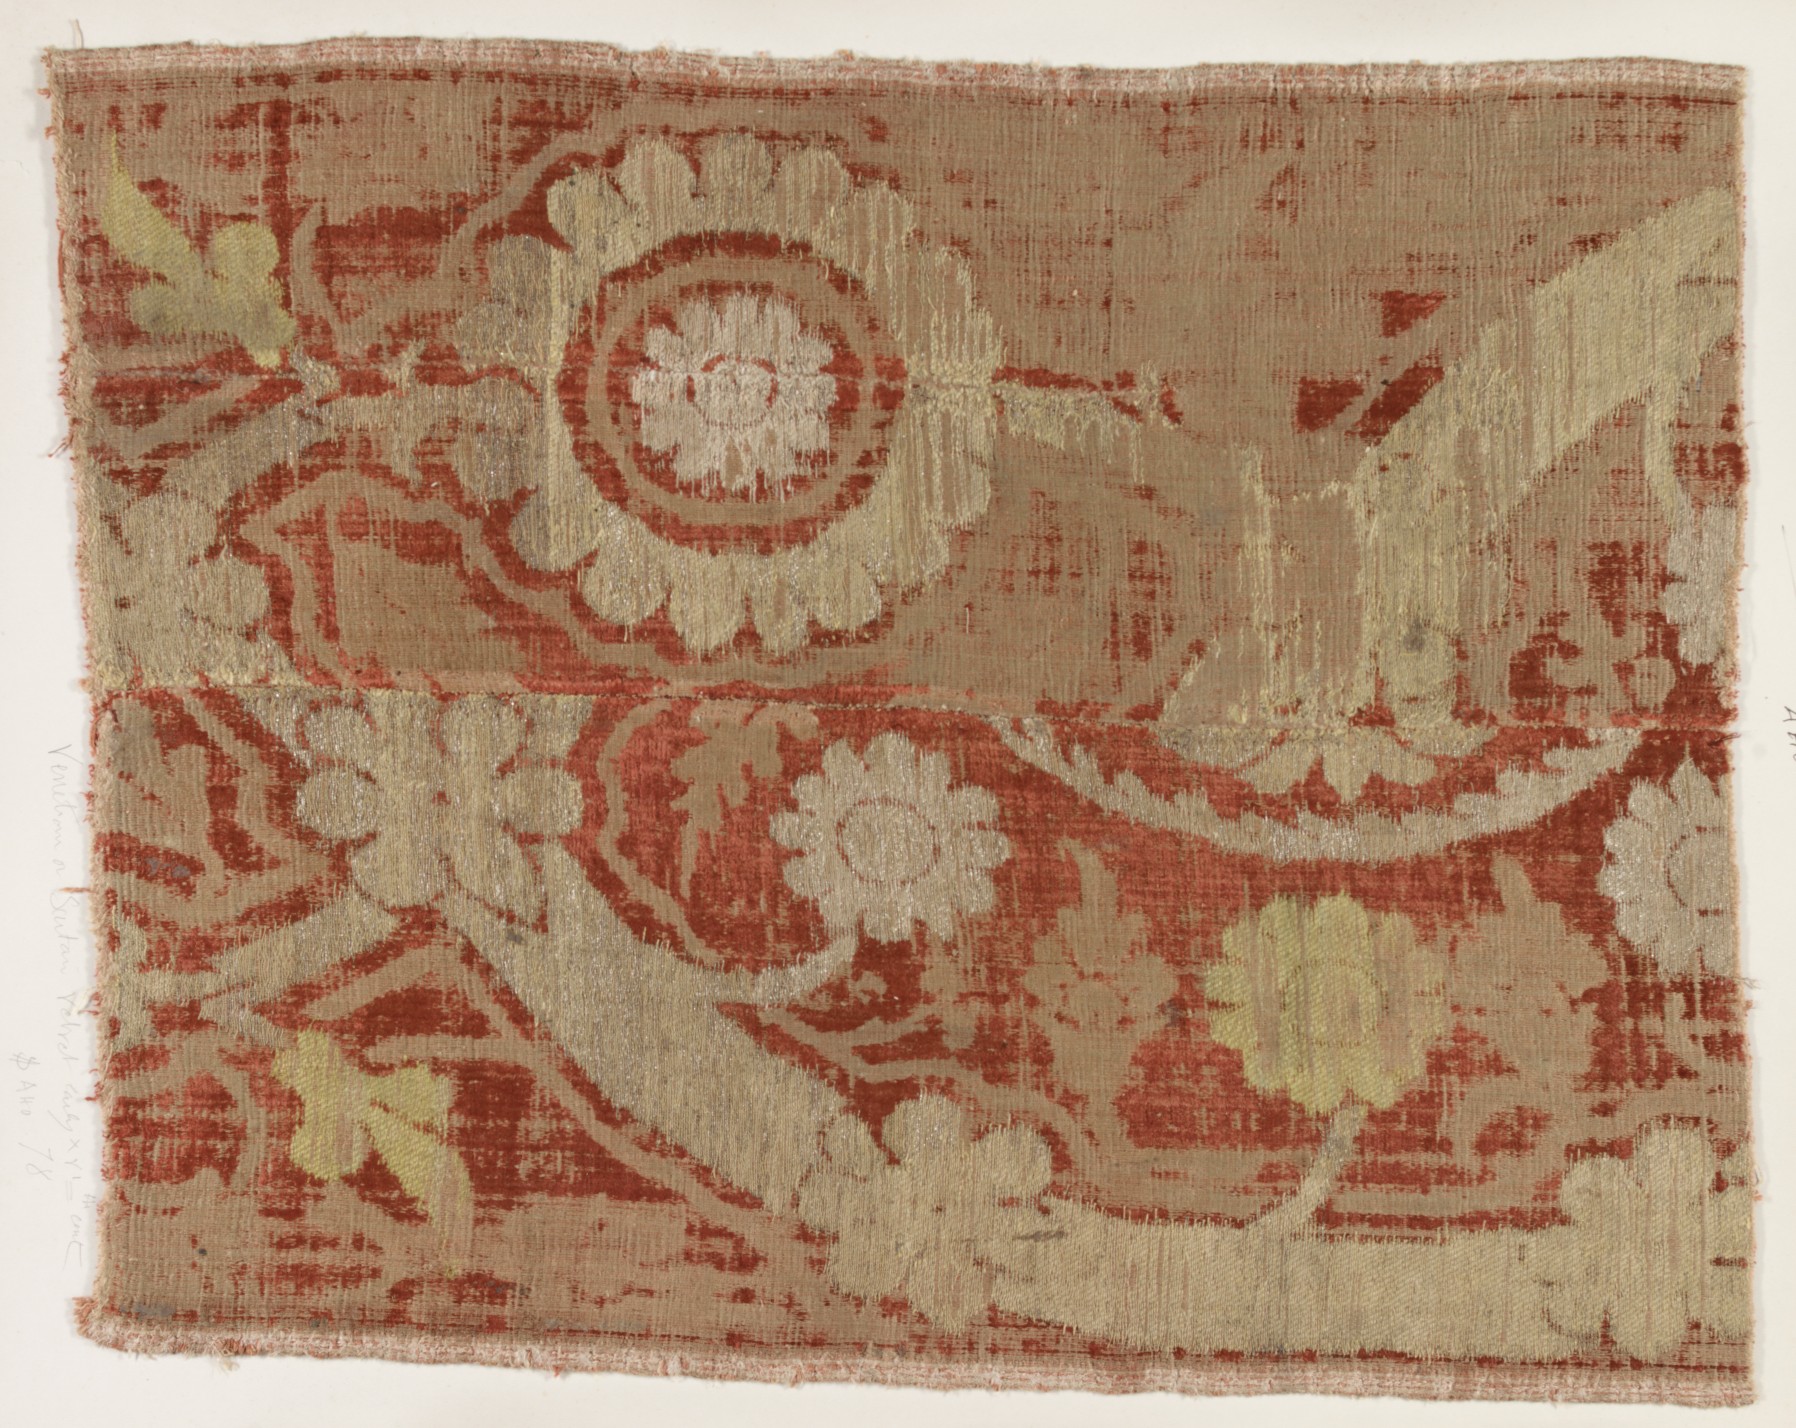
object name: fragment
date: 1501-1533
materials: metal thread, silk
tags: flowers